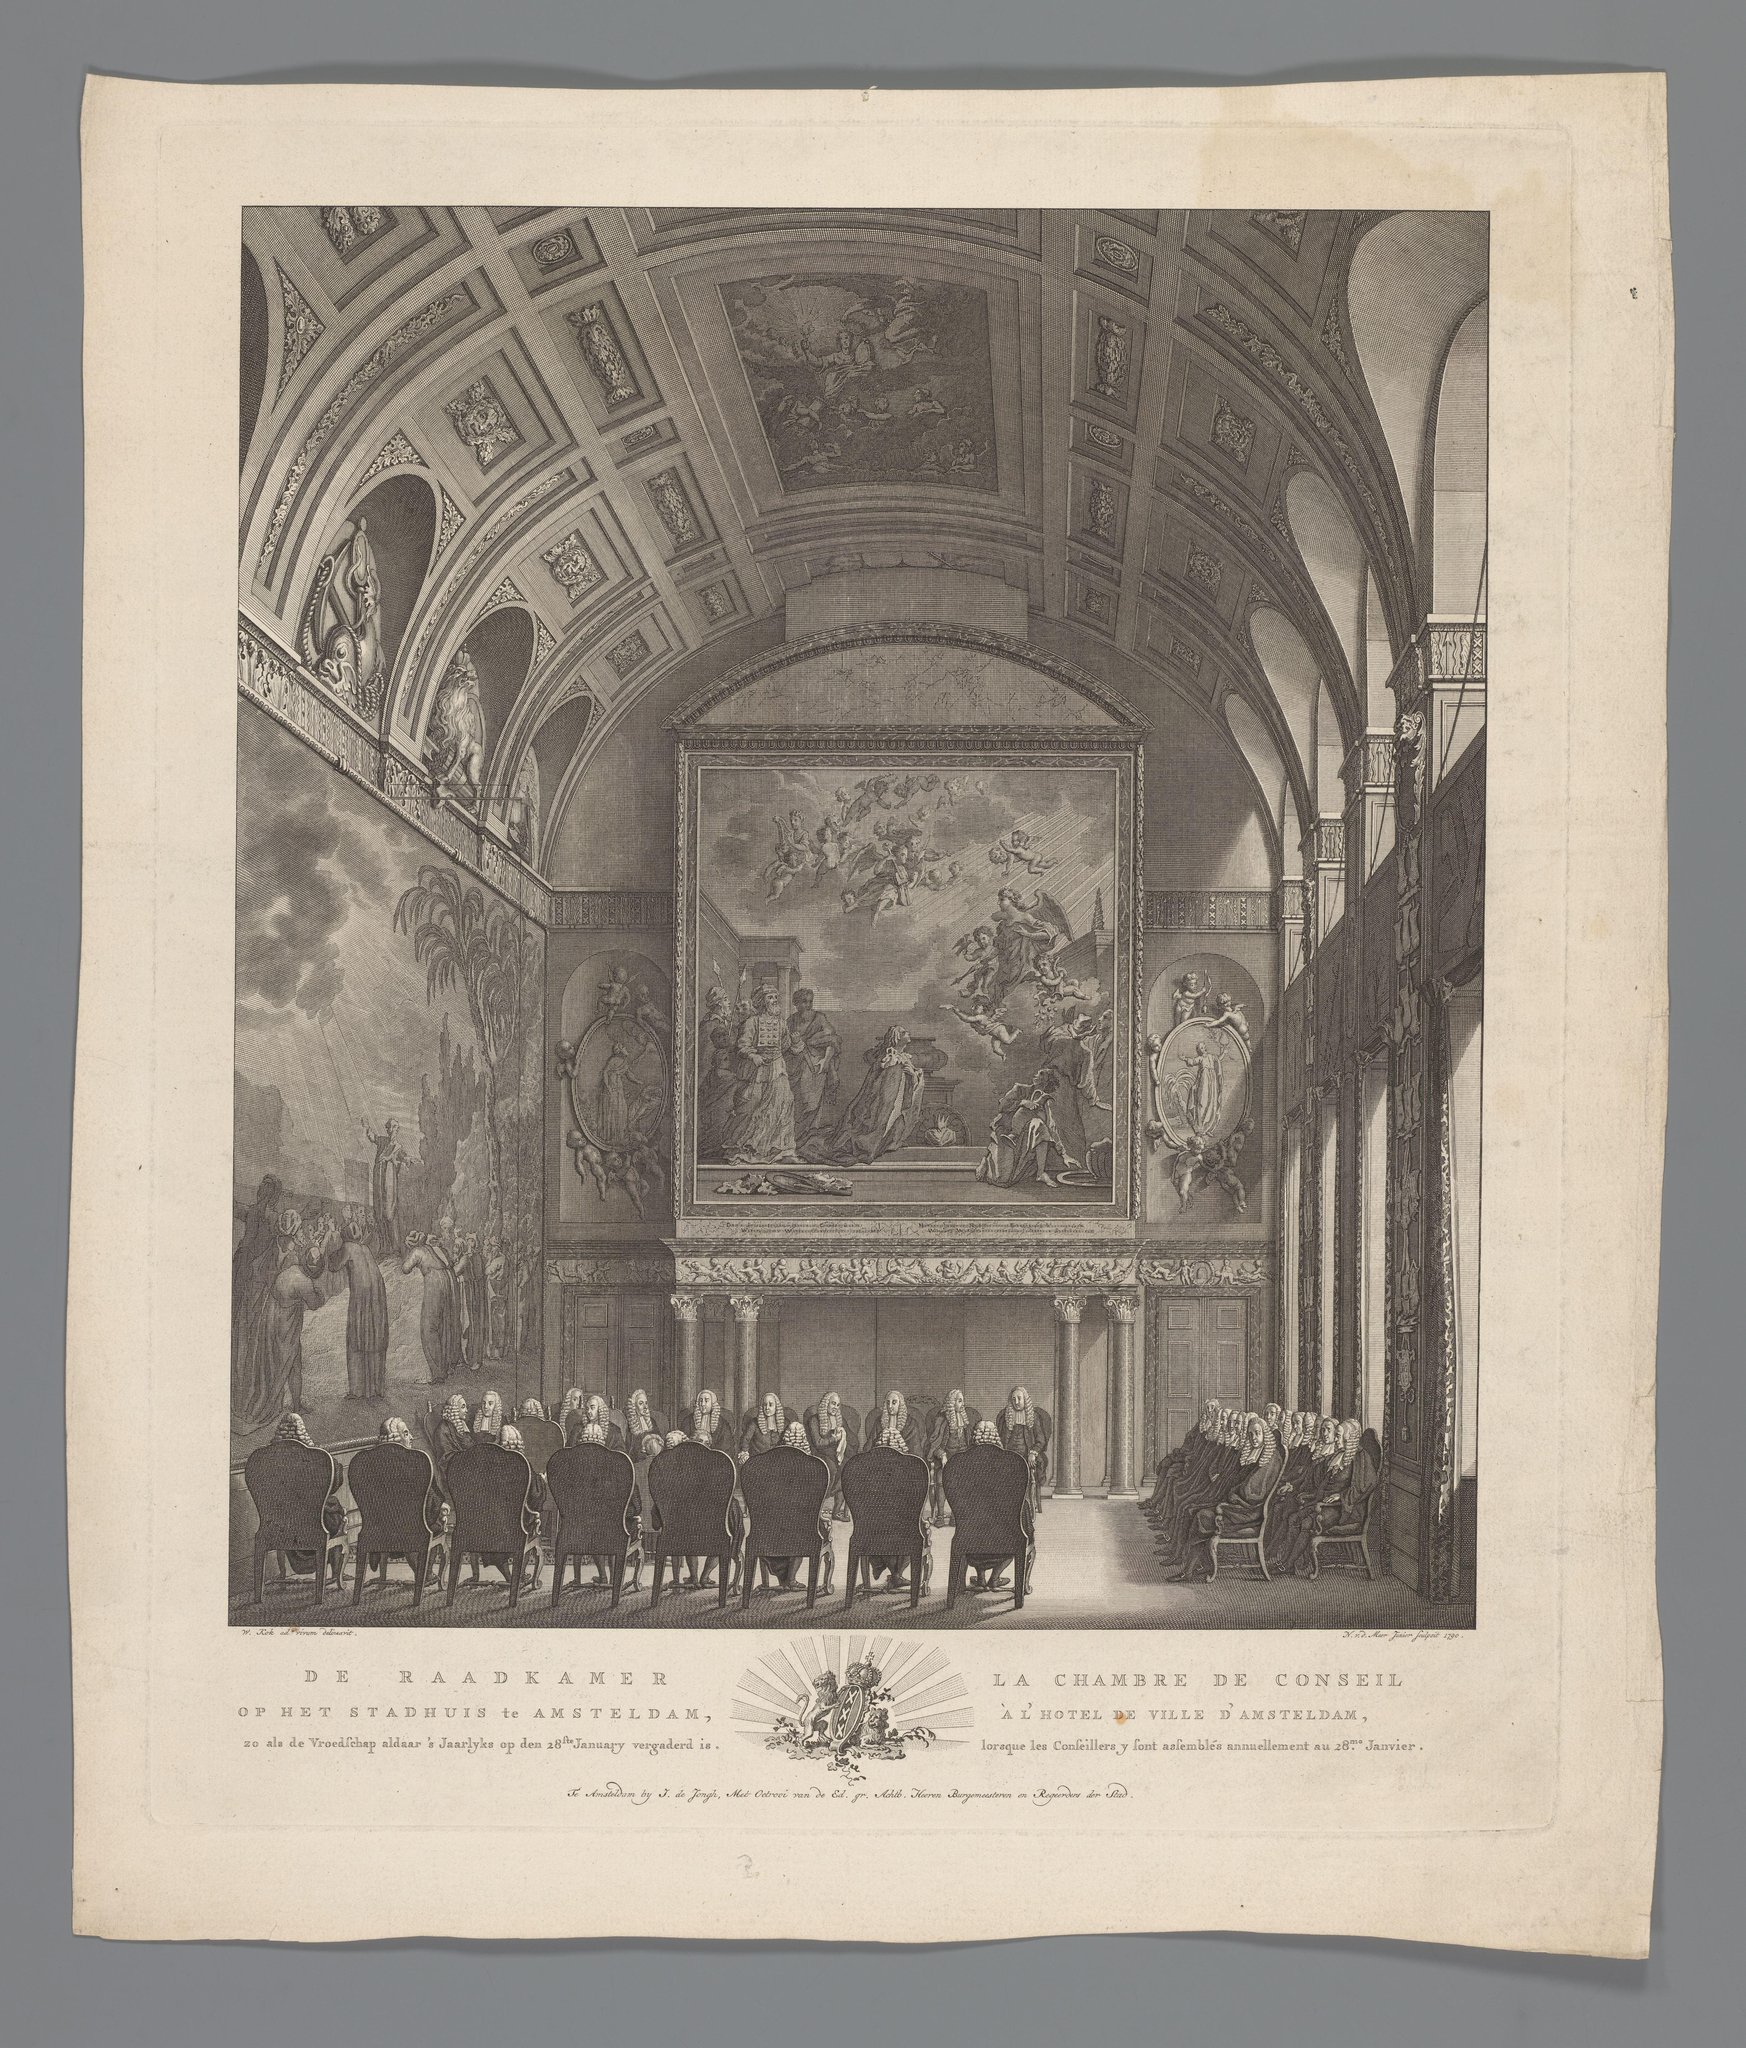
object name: print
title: De raadkamer op het stadhuis te Amsterdam (...) / La chambre de conseil (...)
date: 1790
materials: paper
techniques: engraving, etching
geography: amsterdam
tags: moses chooses seventy elders to assist him and places them round the tabernacle; the spirit of god descends upon them, city council, solomon's prayer for wisdom (1 kings 3:4-15)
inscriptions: date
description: Het interieur van de vroedschapskamer tijdens een vergadering van de vroedschap. Boven de schouw hangt het door Govert Flinck vervaardigde schilderij Salomo's gebed om wijsheid. Links het door Jacob de Wit vervaardigde schilderij De verkiezing van de zeventig oudsten door Mozes. Midden onder in de marge twee leeuwen bij het wapen van Amsterdam.